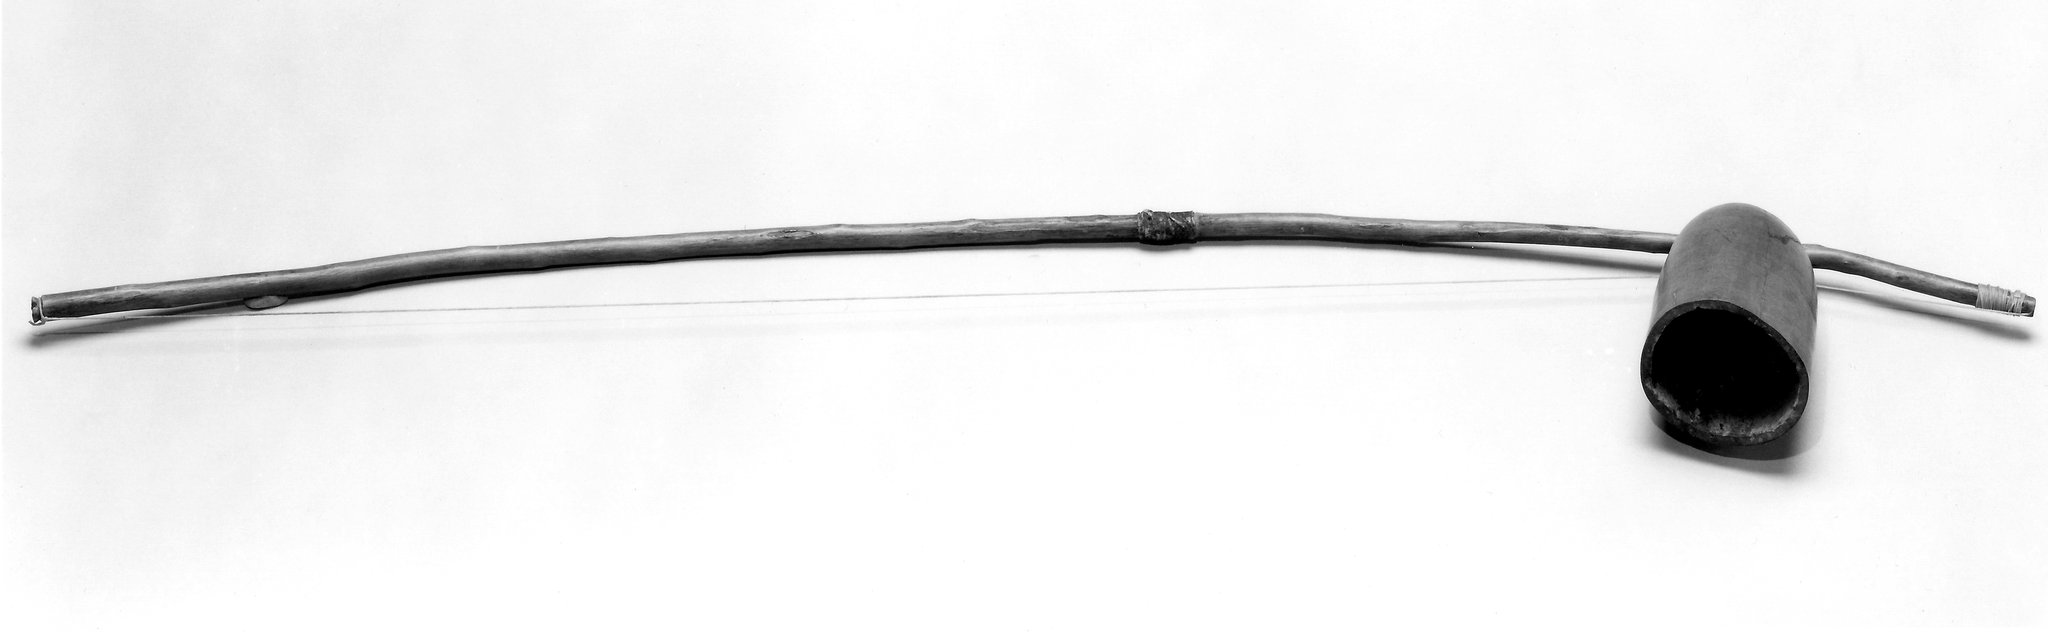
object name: musical bow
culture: west african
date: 1867-1900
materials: hemp, wood